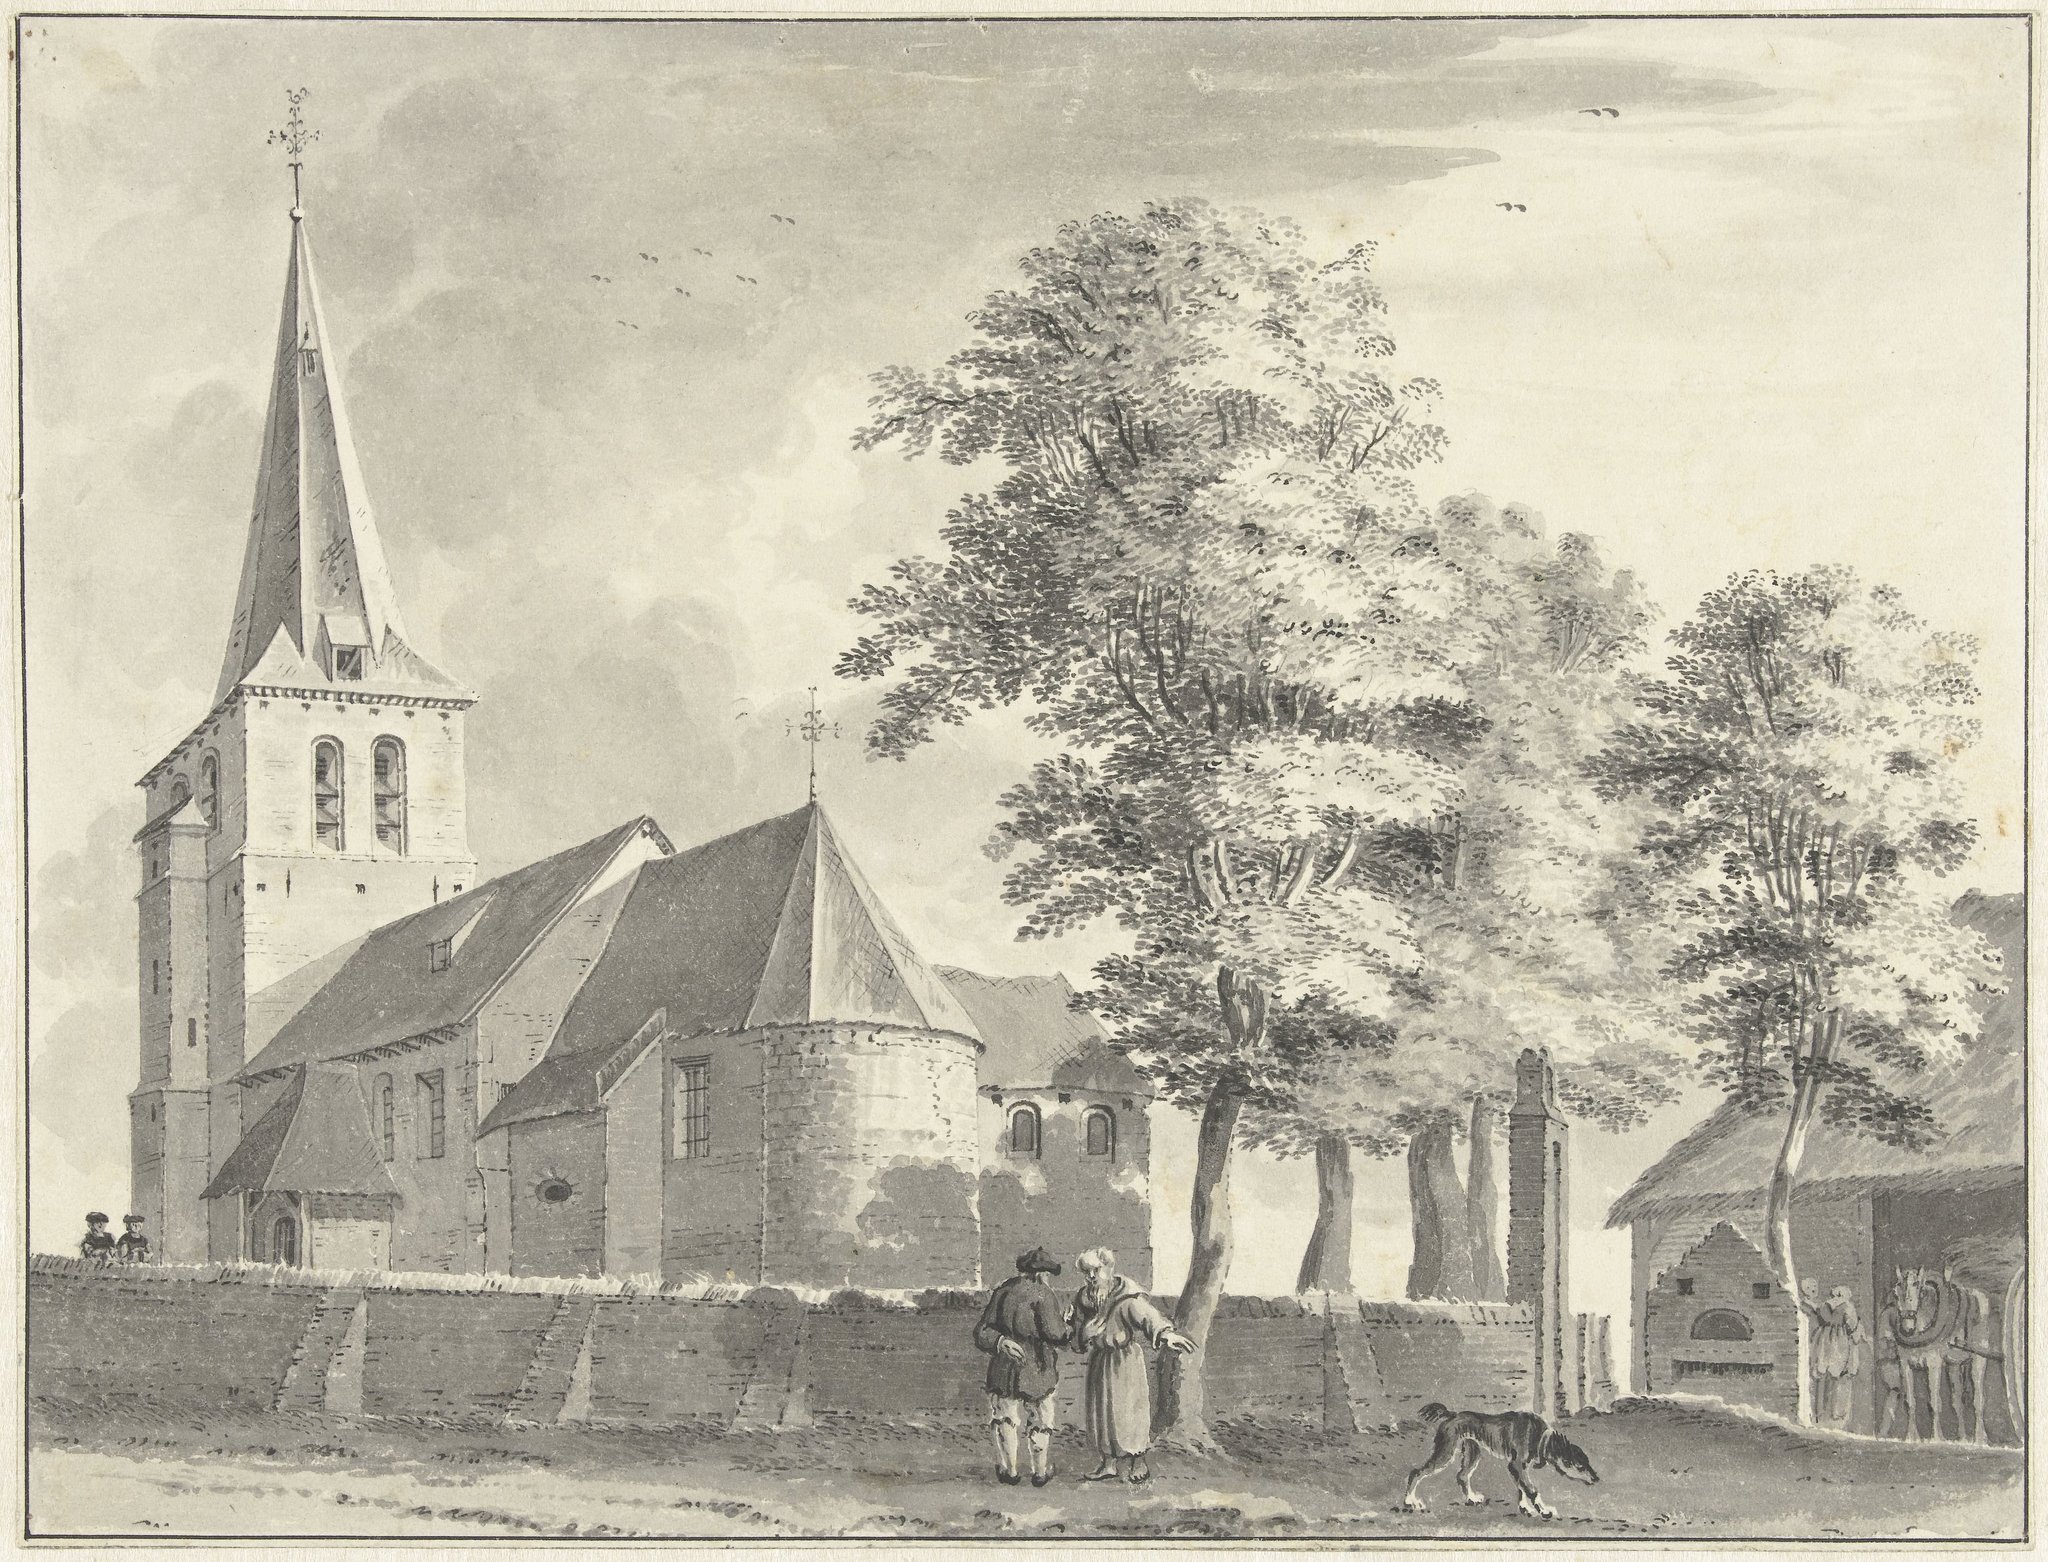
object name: drawing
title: De kerk van Steinkirchen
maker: jan de beijer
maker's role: draughtsman, print maker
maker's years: 1703-1780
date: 1713-1780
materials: ink, paper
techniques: brush, pen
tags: church (exterior), germany